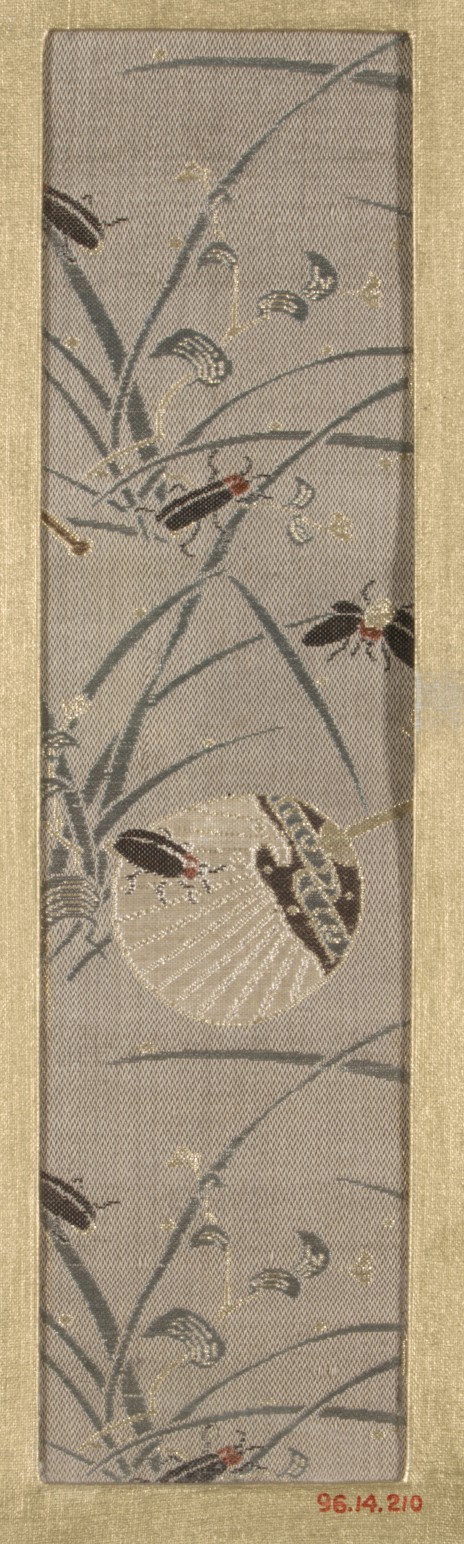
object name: piece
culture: japanese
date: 1701-1900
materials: silk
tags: leaves